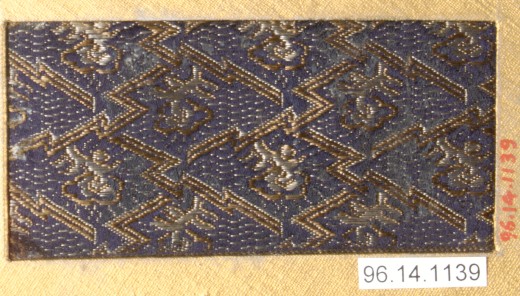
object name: piece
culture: japanese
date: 1701-1900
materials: silk